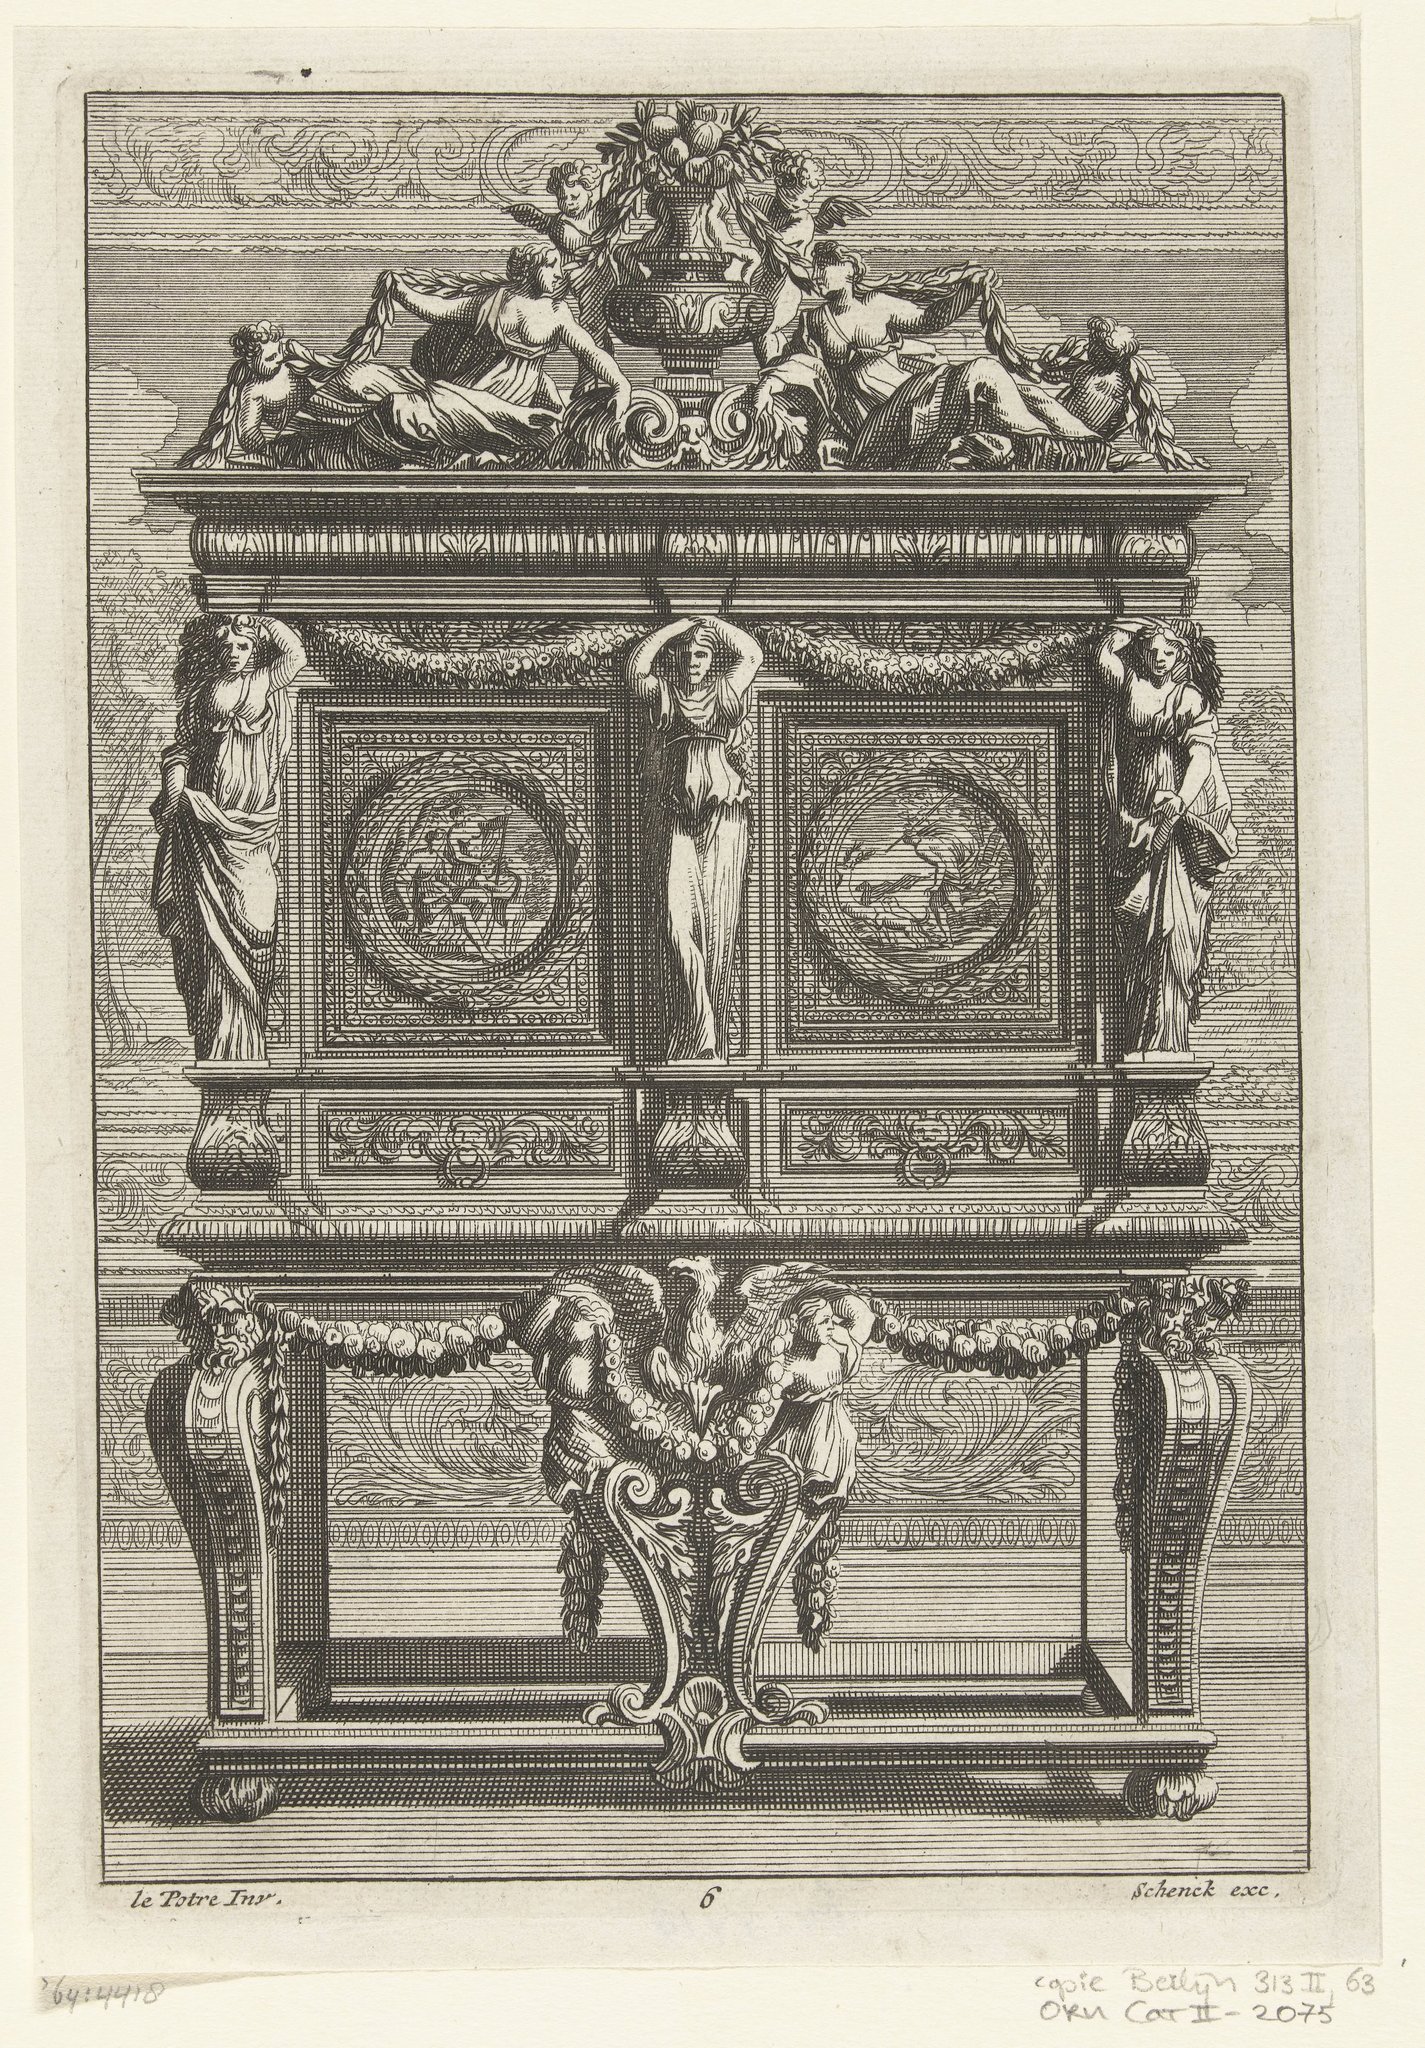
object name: ornament print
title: Kabinet met twee deuren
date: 1680-1700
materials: paper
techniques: etching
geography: netherlands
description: In de hoeken en in het midden staat een kariatide.